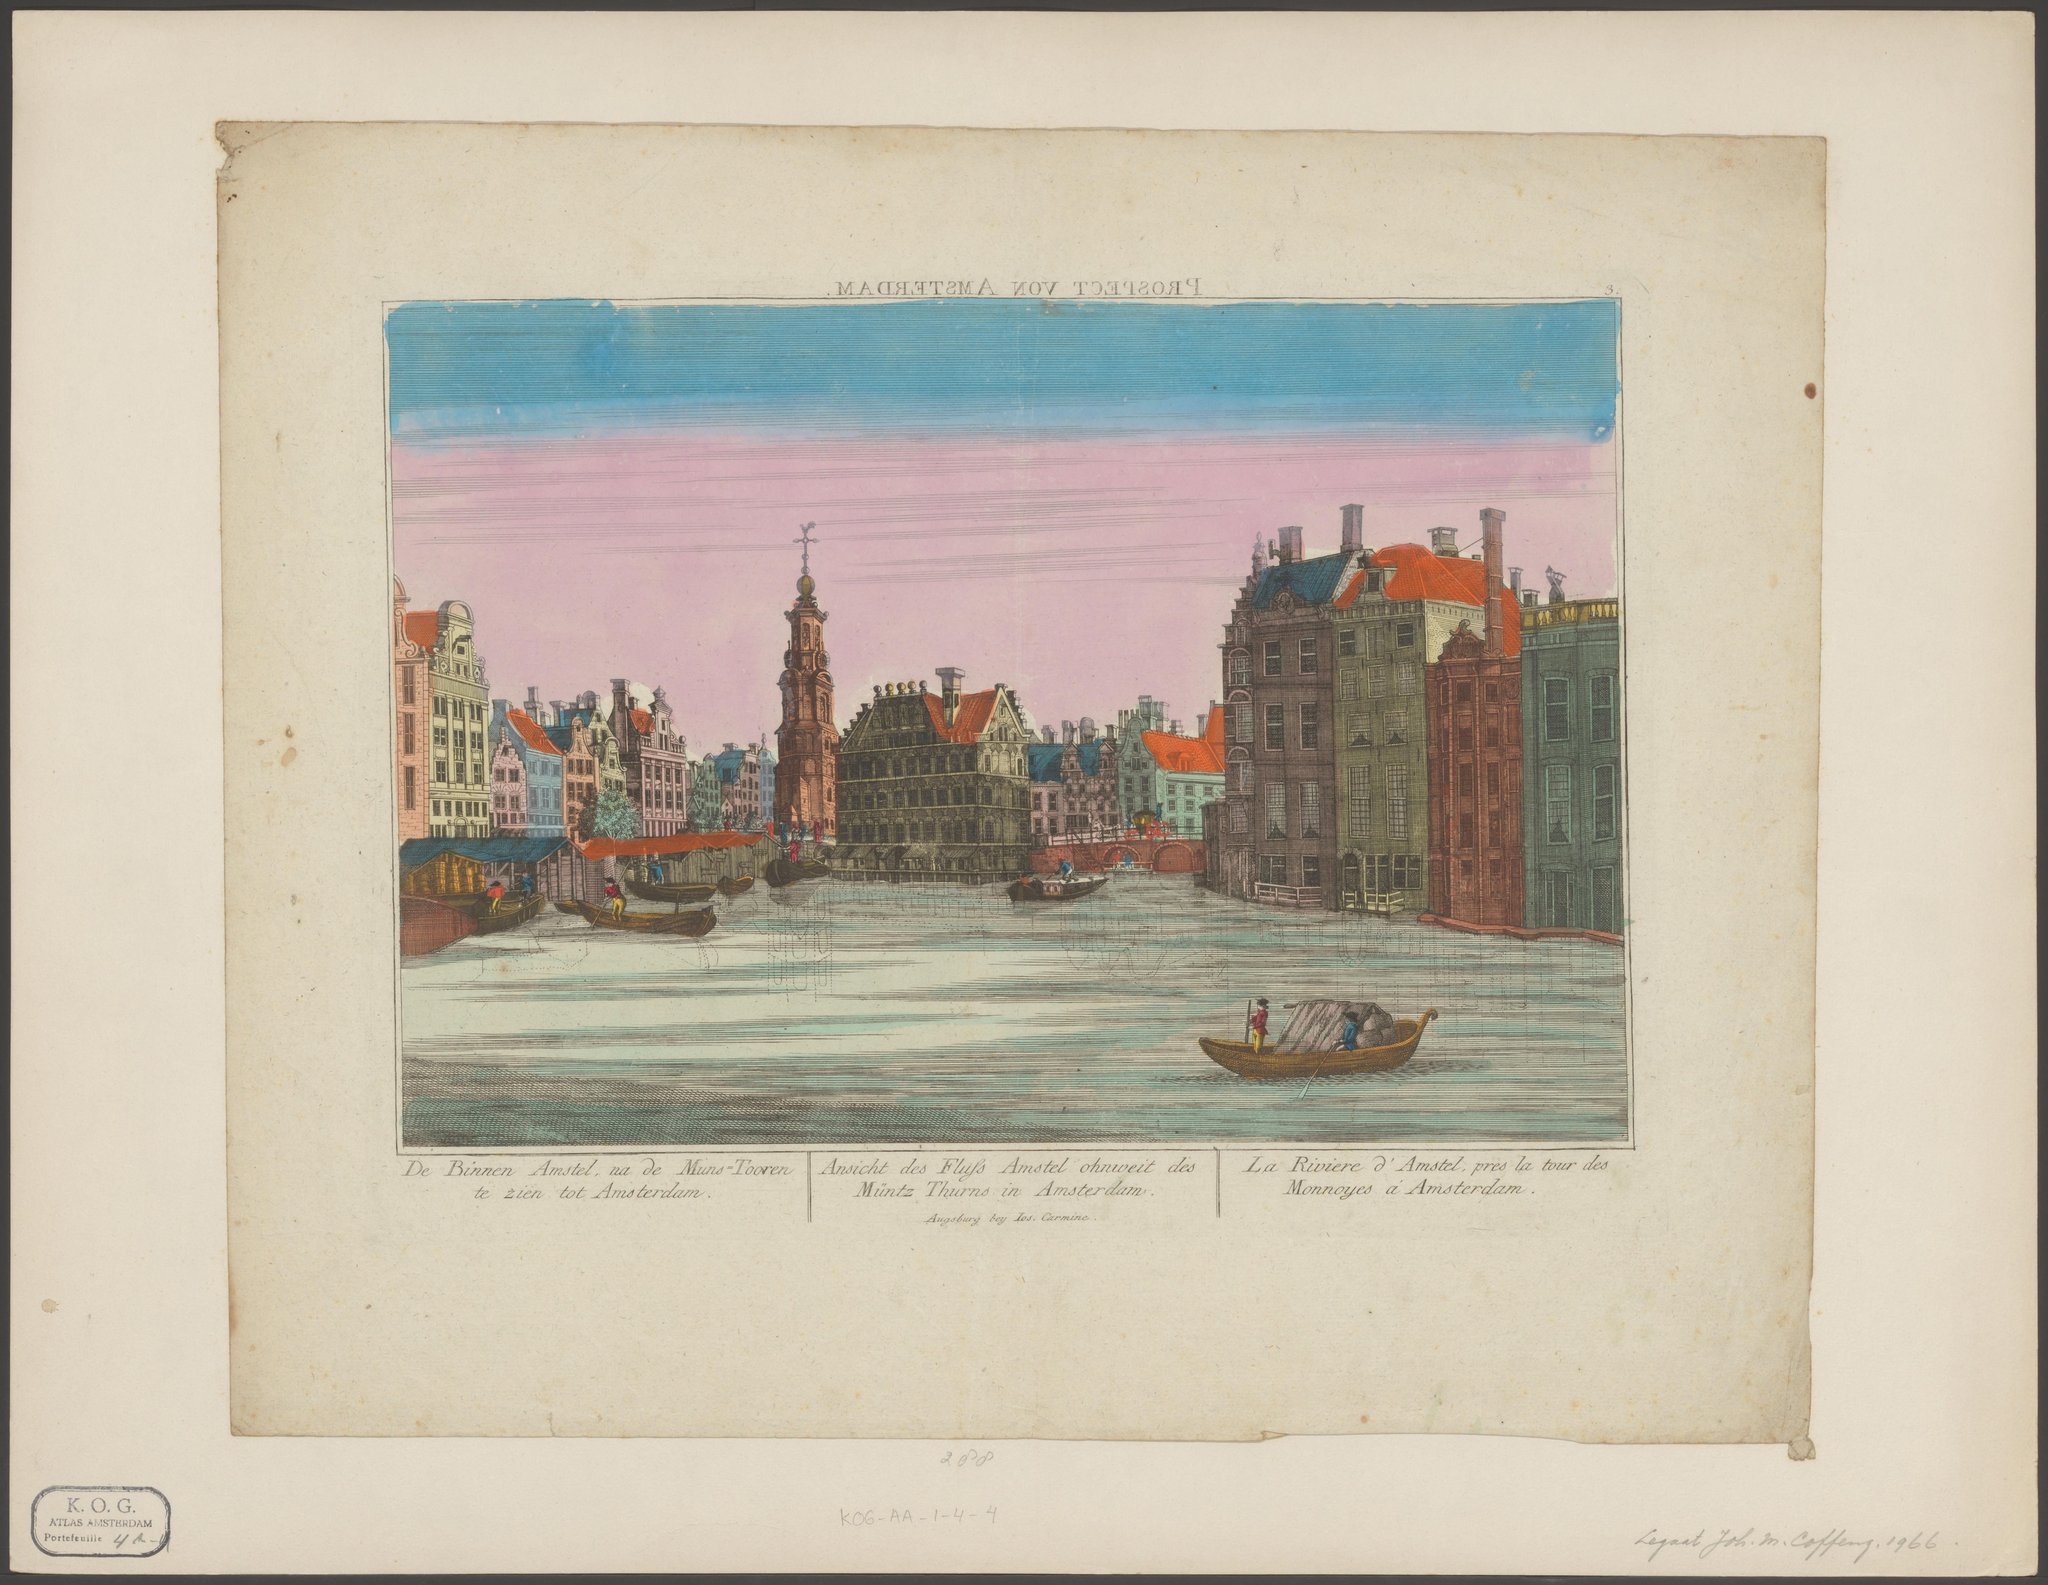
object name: print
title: Gezicht op de Binnen-Amstel en de Munttoren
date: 1780-1830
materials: paper, watercolor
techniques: brush, engraving, etching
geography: augsburg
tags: city-view in general; 'veduta', canal, façade (of house or building), bridge in city across river, canal, etc., boat propelled by man or animal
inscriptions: inscription: ‘Legaat Joh. M. Coffeng. 1966.’, collector's mark: ‘4A-4’ Lugt 1641b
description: Onderwerpsrubriek binnen de Atlas Amsterdam: Amstel van Doelensluis tot Blauwbrug. Rechtsboven genummerd: 3.